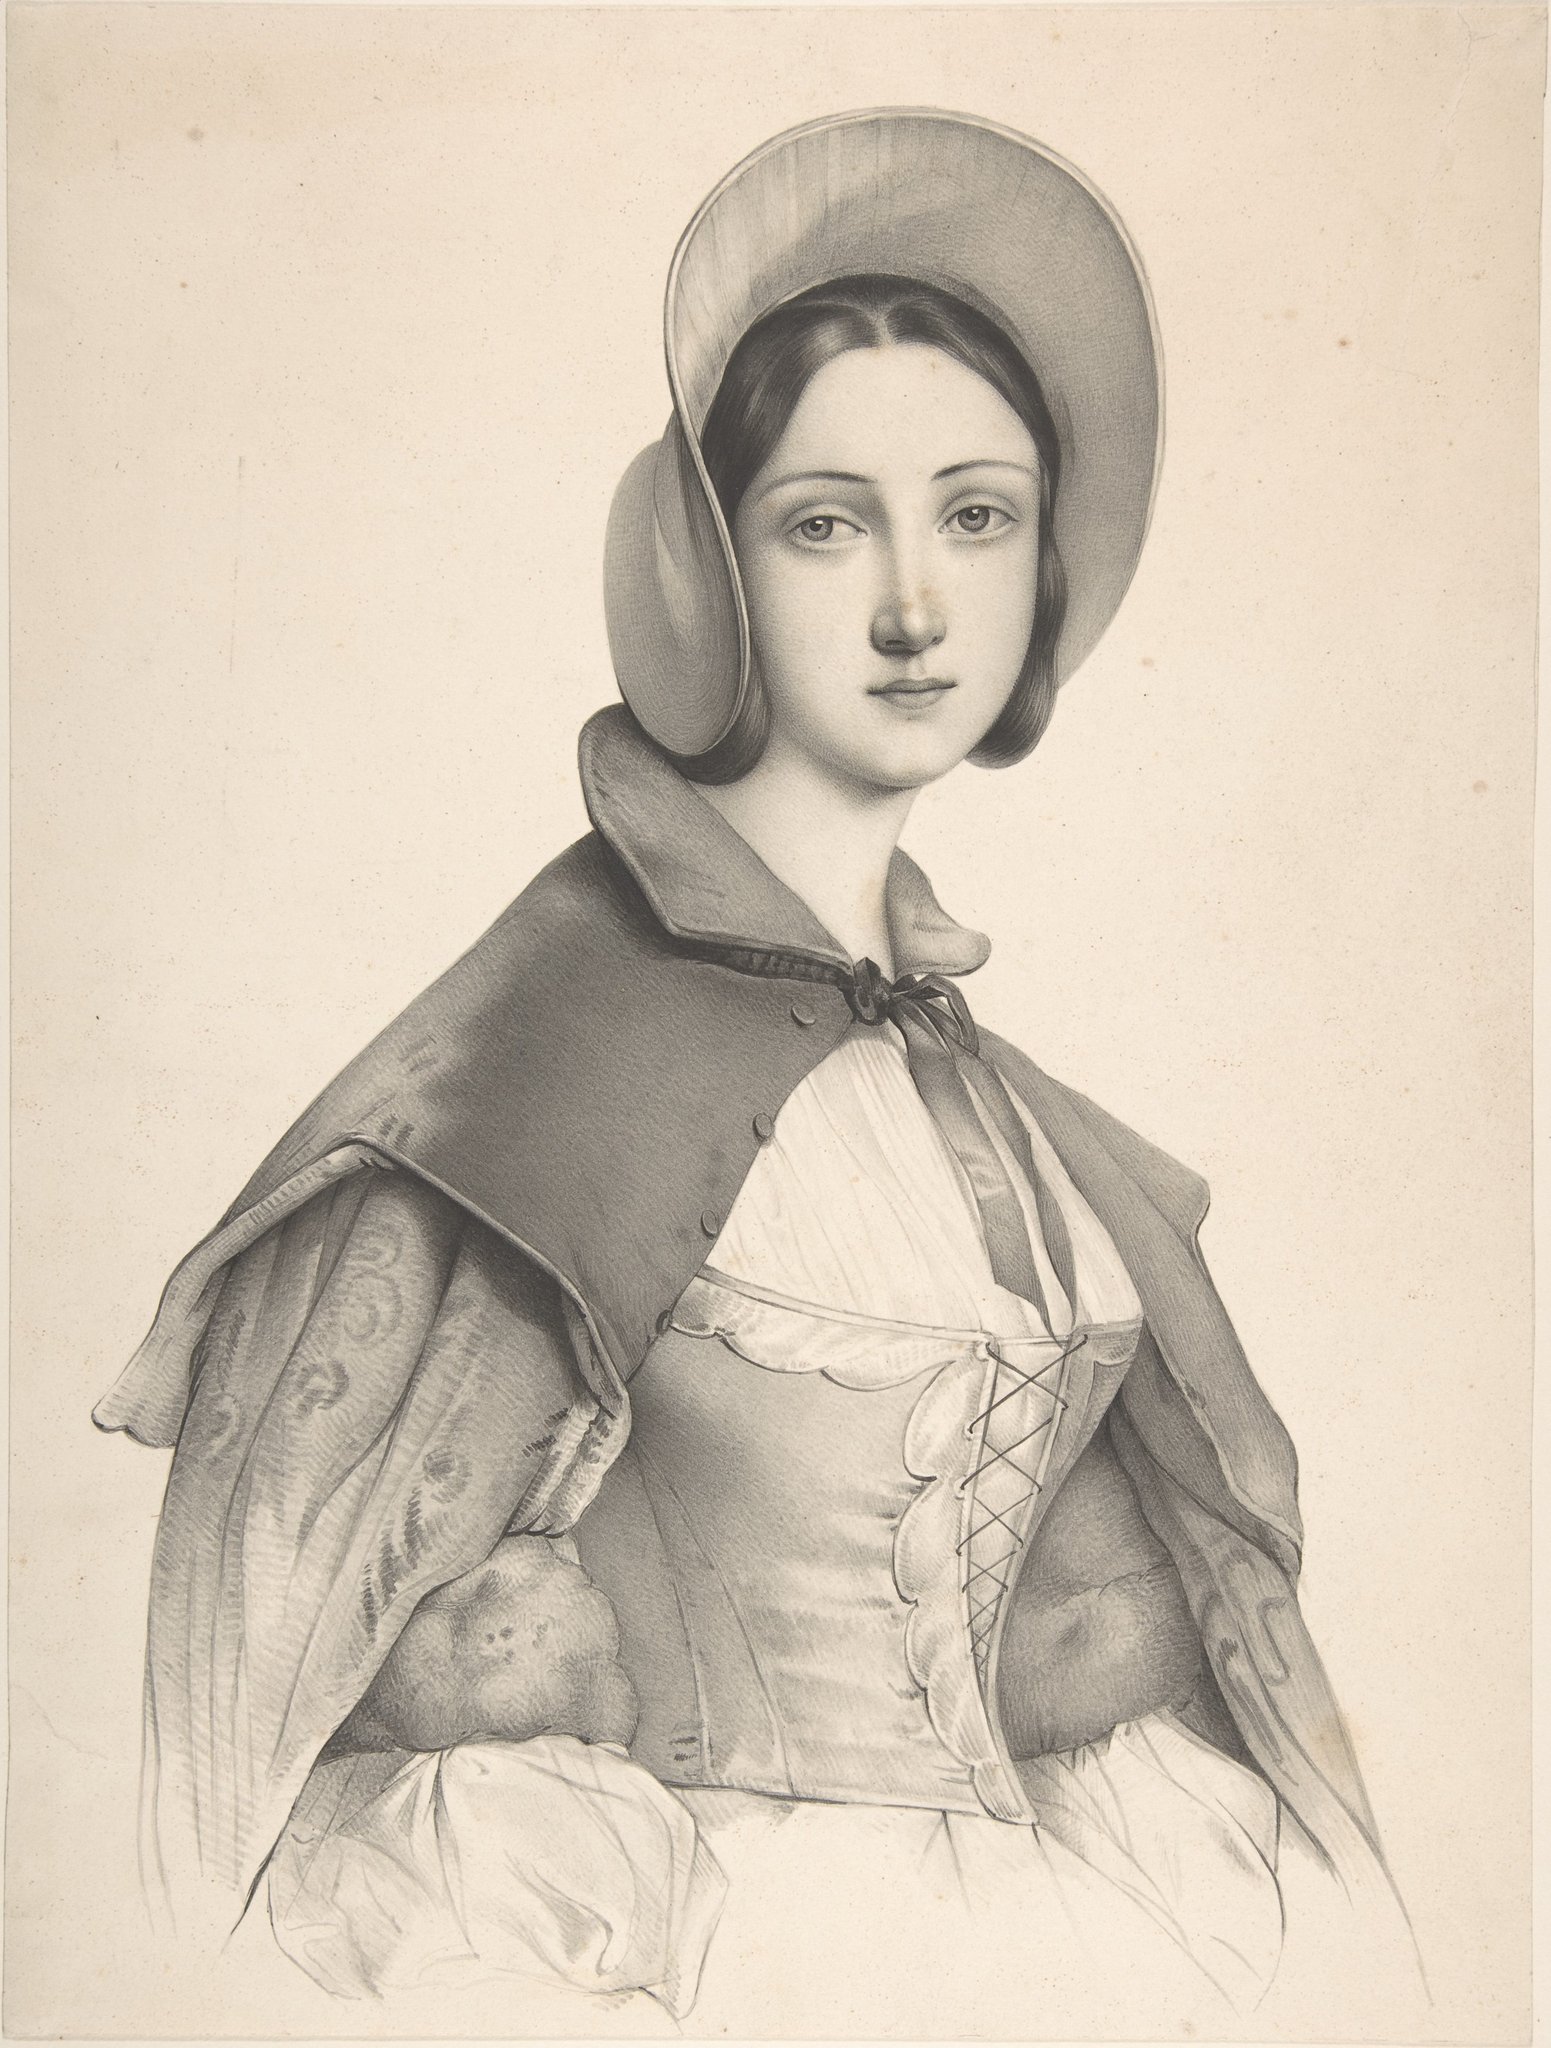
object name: drawing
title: Portrait of a Woman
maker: anonymous, french, 19th century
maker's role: artist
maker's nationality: french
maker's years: 1800-1900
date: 1801-1900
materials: graphite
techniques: brush, heightening, wash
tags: portraits,women